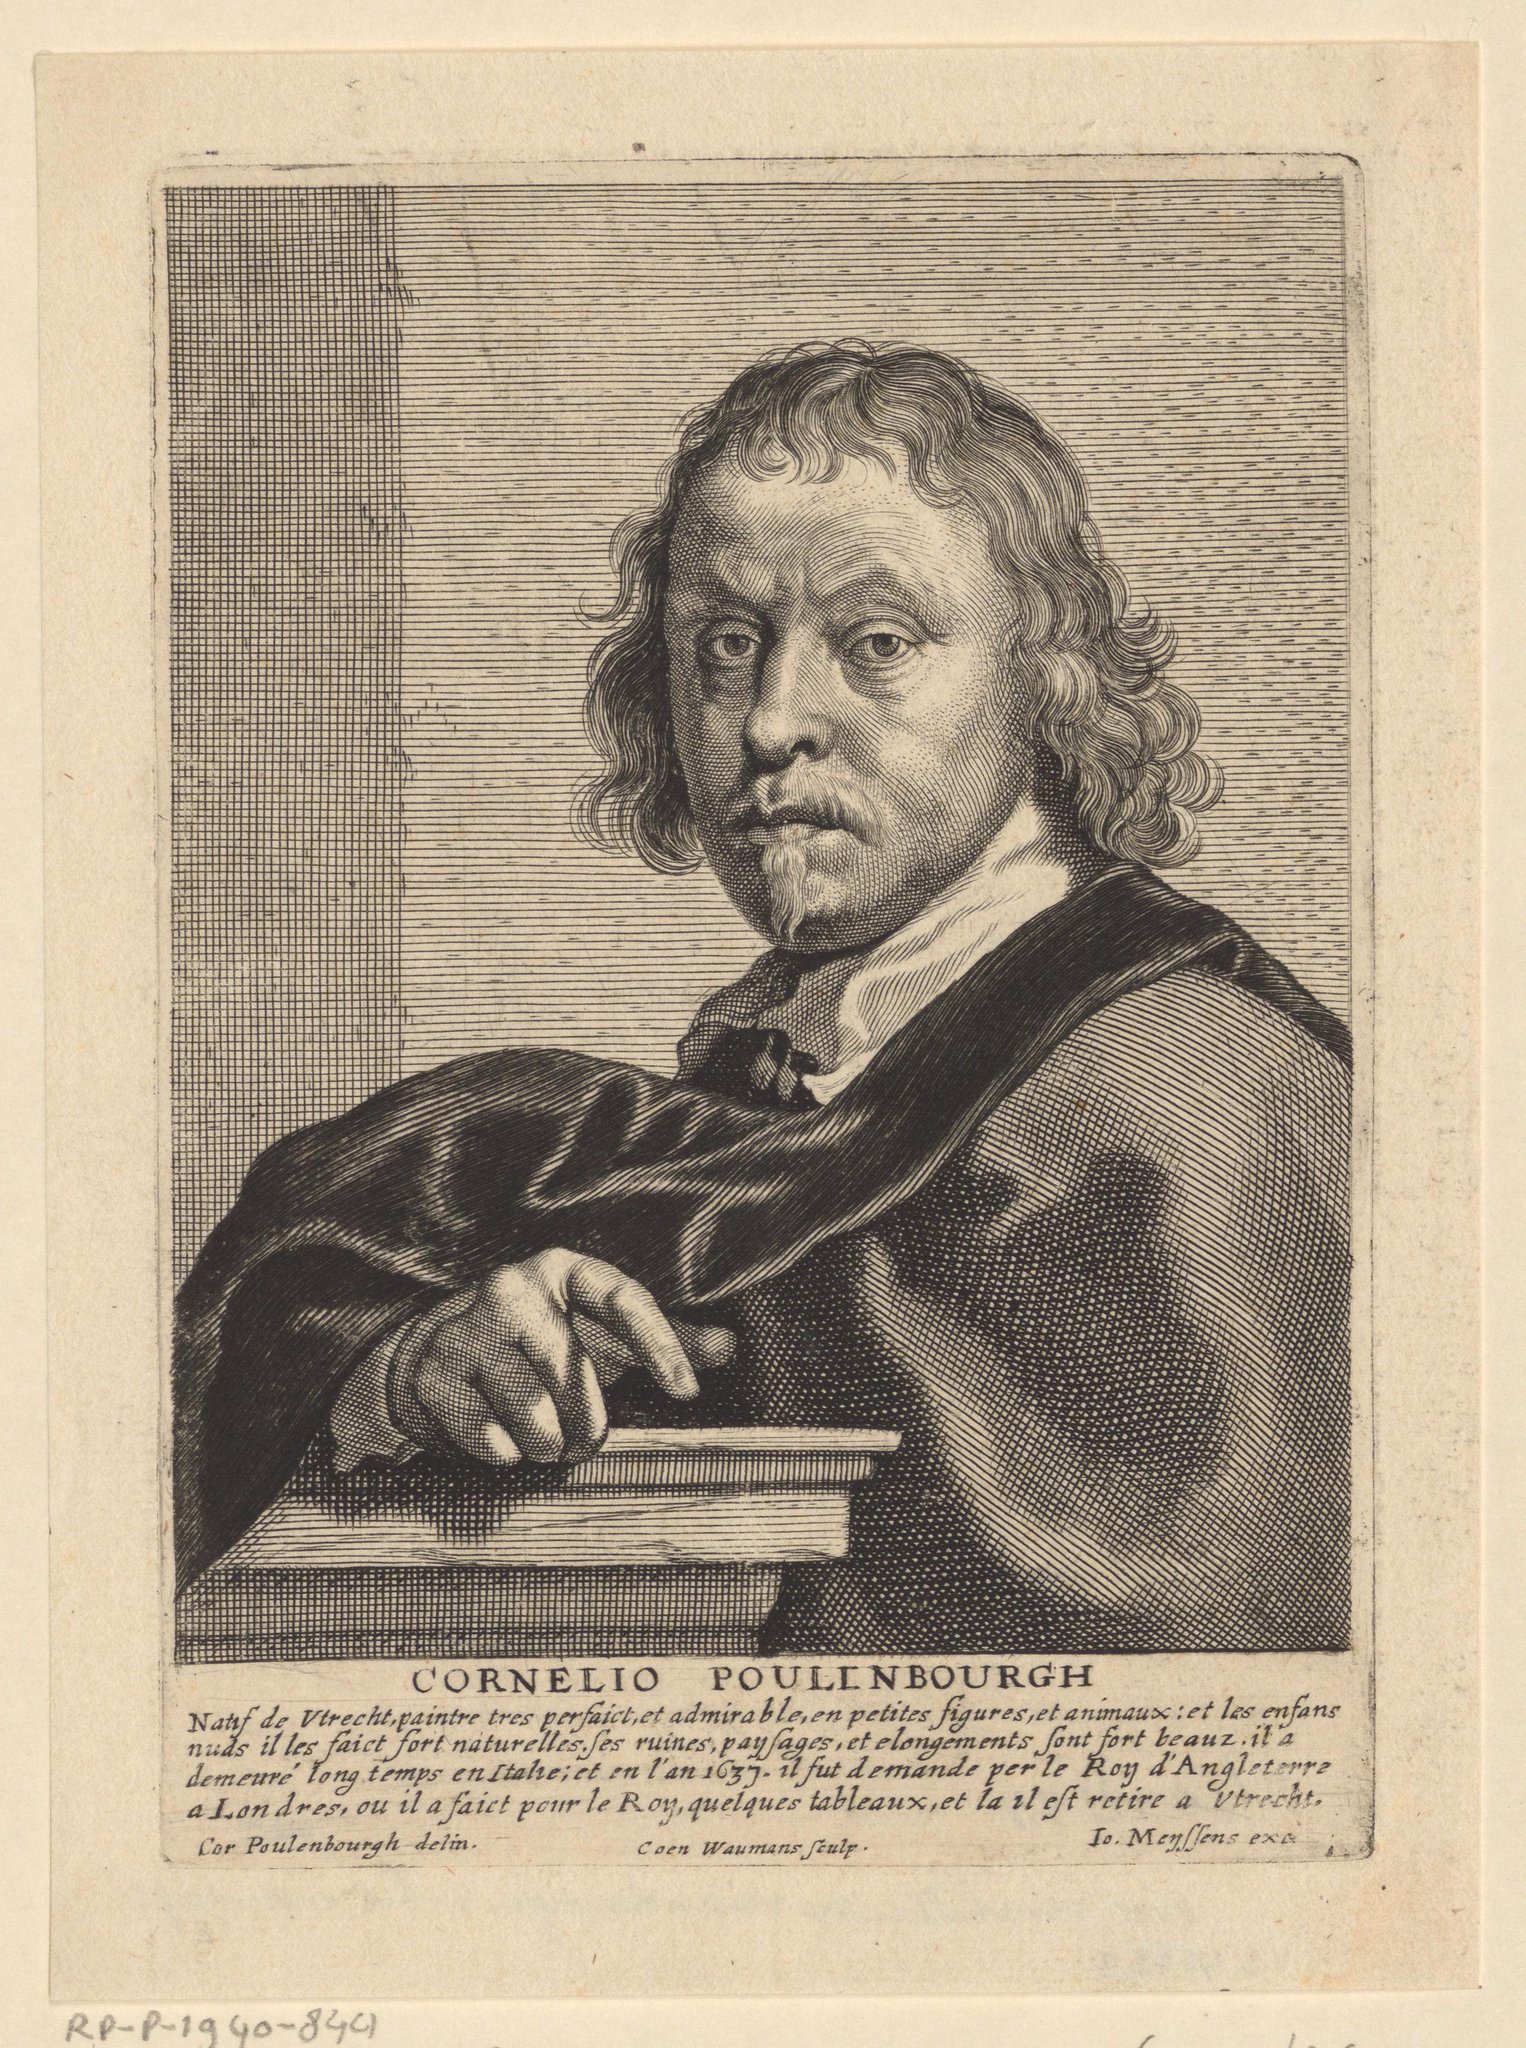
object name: print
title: Portret van Cornelis van Poelenburch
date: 1649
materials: paper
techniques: engraving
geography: antwerp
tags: utrecht, painter, draughtsman, cornelis van poelenburch, historical persons, portrait, self-portrait of painter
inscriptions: collector's mark: Lugt 2760, collector's mark: Lugt 2228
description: Prent mogelijk uit: Image de divers hommes d'esprit sublime, qui par leur art et science devraient vivre éternellement et desquels la louange et renommée faict estonner le monde. Antwerpen: Joannes Meyssens, 1649. Prent met tekst op verso gebruikt in: Bie, Cornelis de. Het gulden cabinet vande edel vry schilder const (...). Antwerpen: Joannes Meyssens, 1662 [1661 foutief op titelpagina], p. 257.